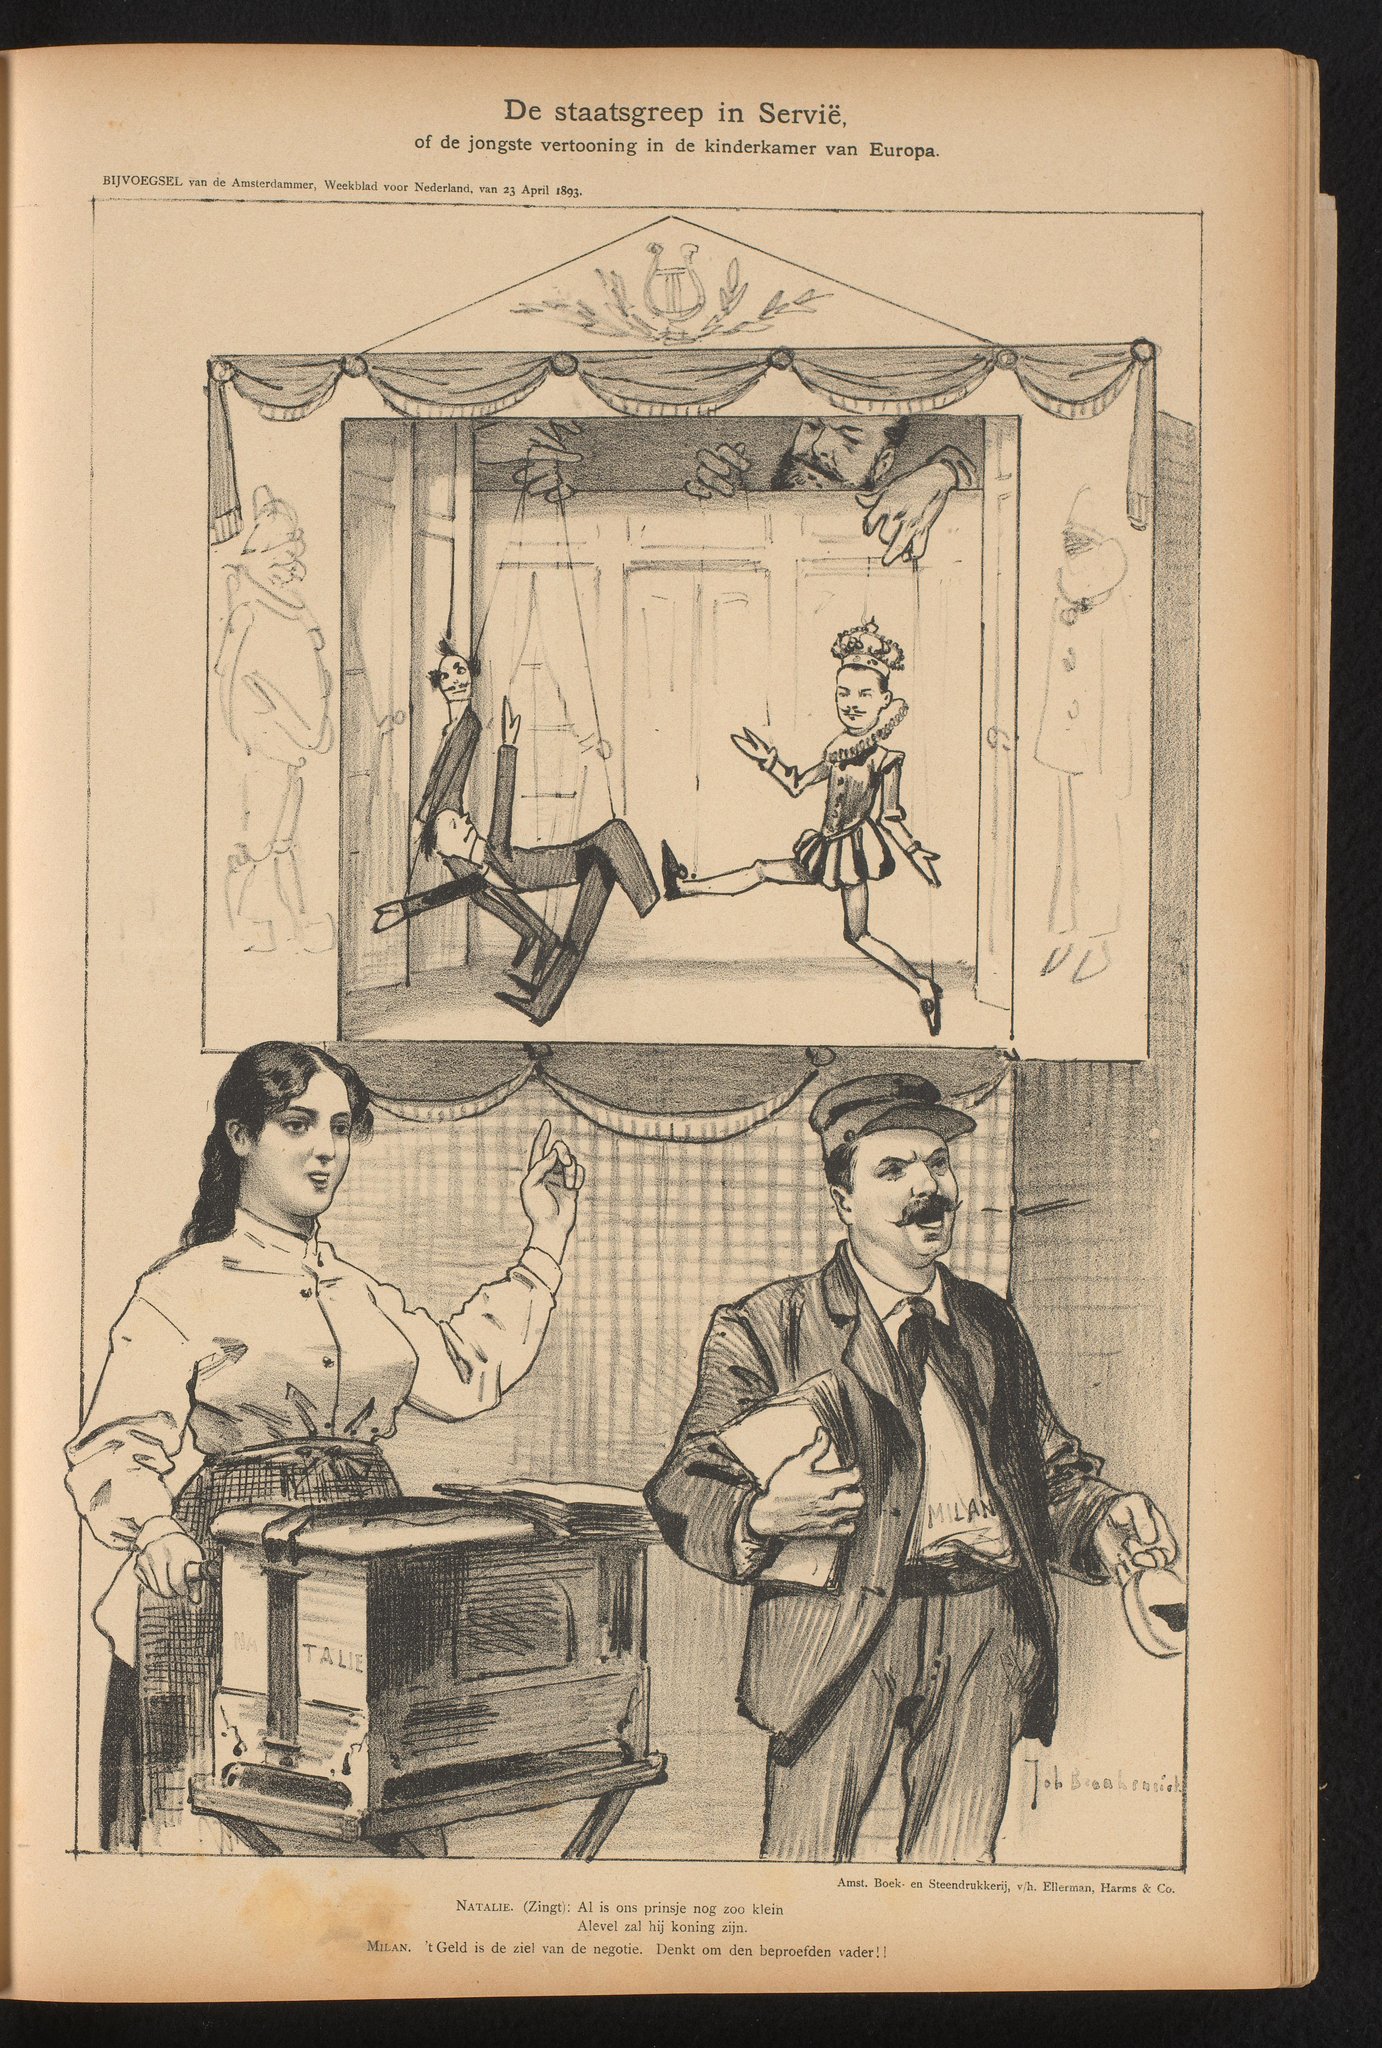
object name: cartoon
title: De staatsgreep in Servië, of de jongste vertooning in de kinderkamer van Europa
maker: johan braakensiek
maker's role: draughtsman, print maker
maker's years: 1858-1940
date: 1893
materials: paper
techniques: lithograph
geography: netherlands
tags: vienna, revolutionary government, the old government and its supporters (after revolution), marionette, barrel-organ player, political caricatures and satires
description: Koning Milan I van Servië en zijn vrouw koningin Natalija Keško met een draaiorgel halen geld op bij een poppenkast met marionettenvoorstelling van de staatsgreep door hun zoon koning Alexander Obrenović van Servië.